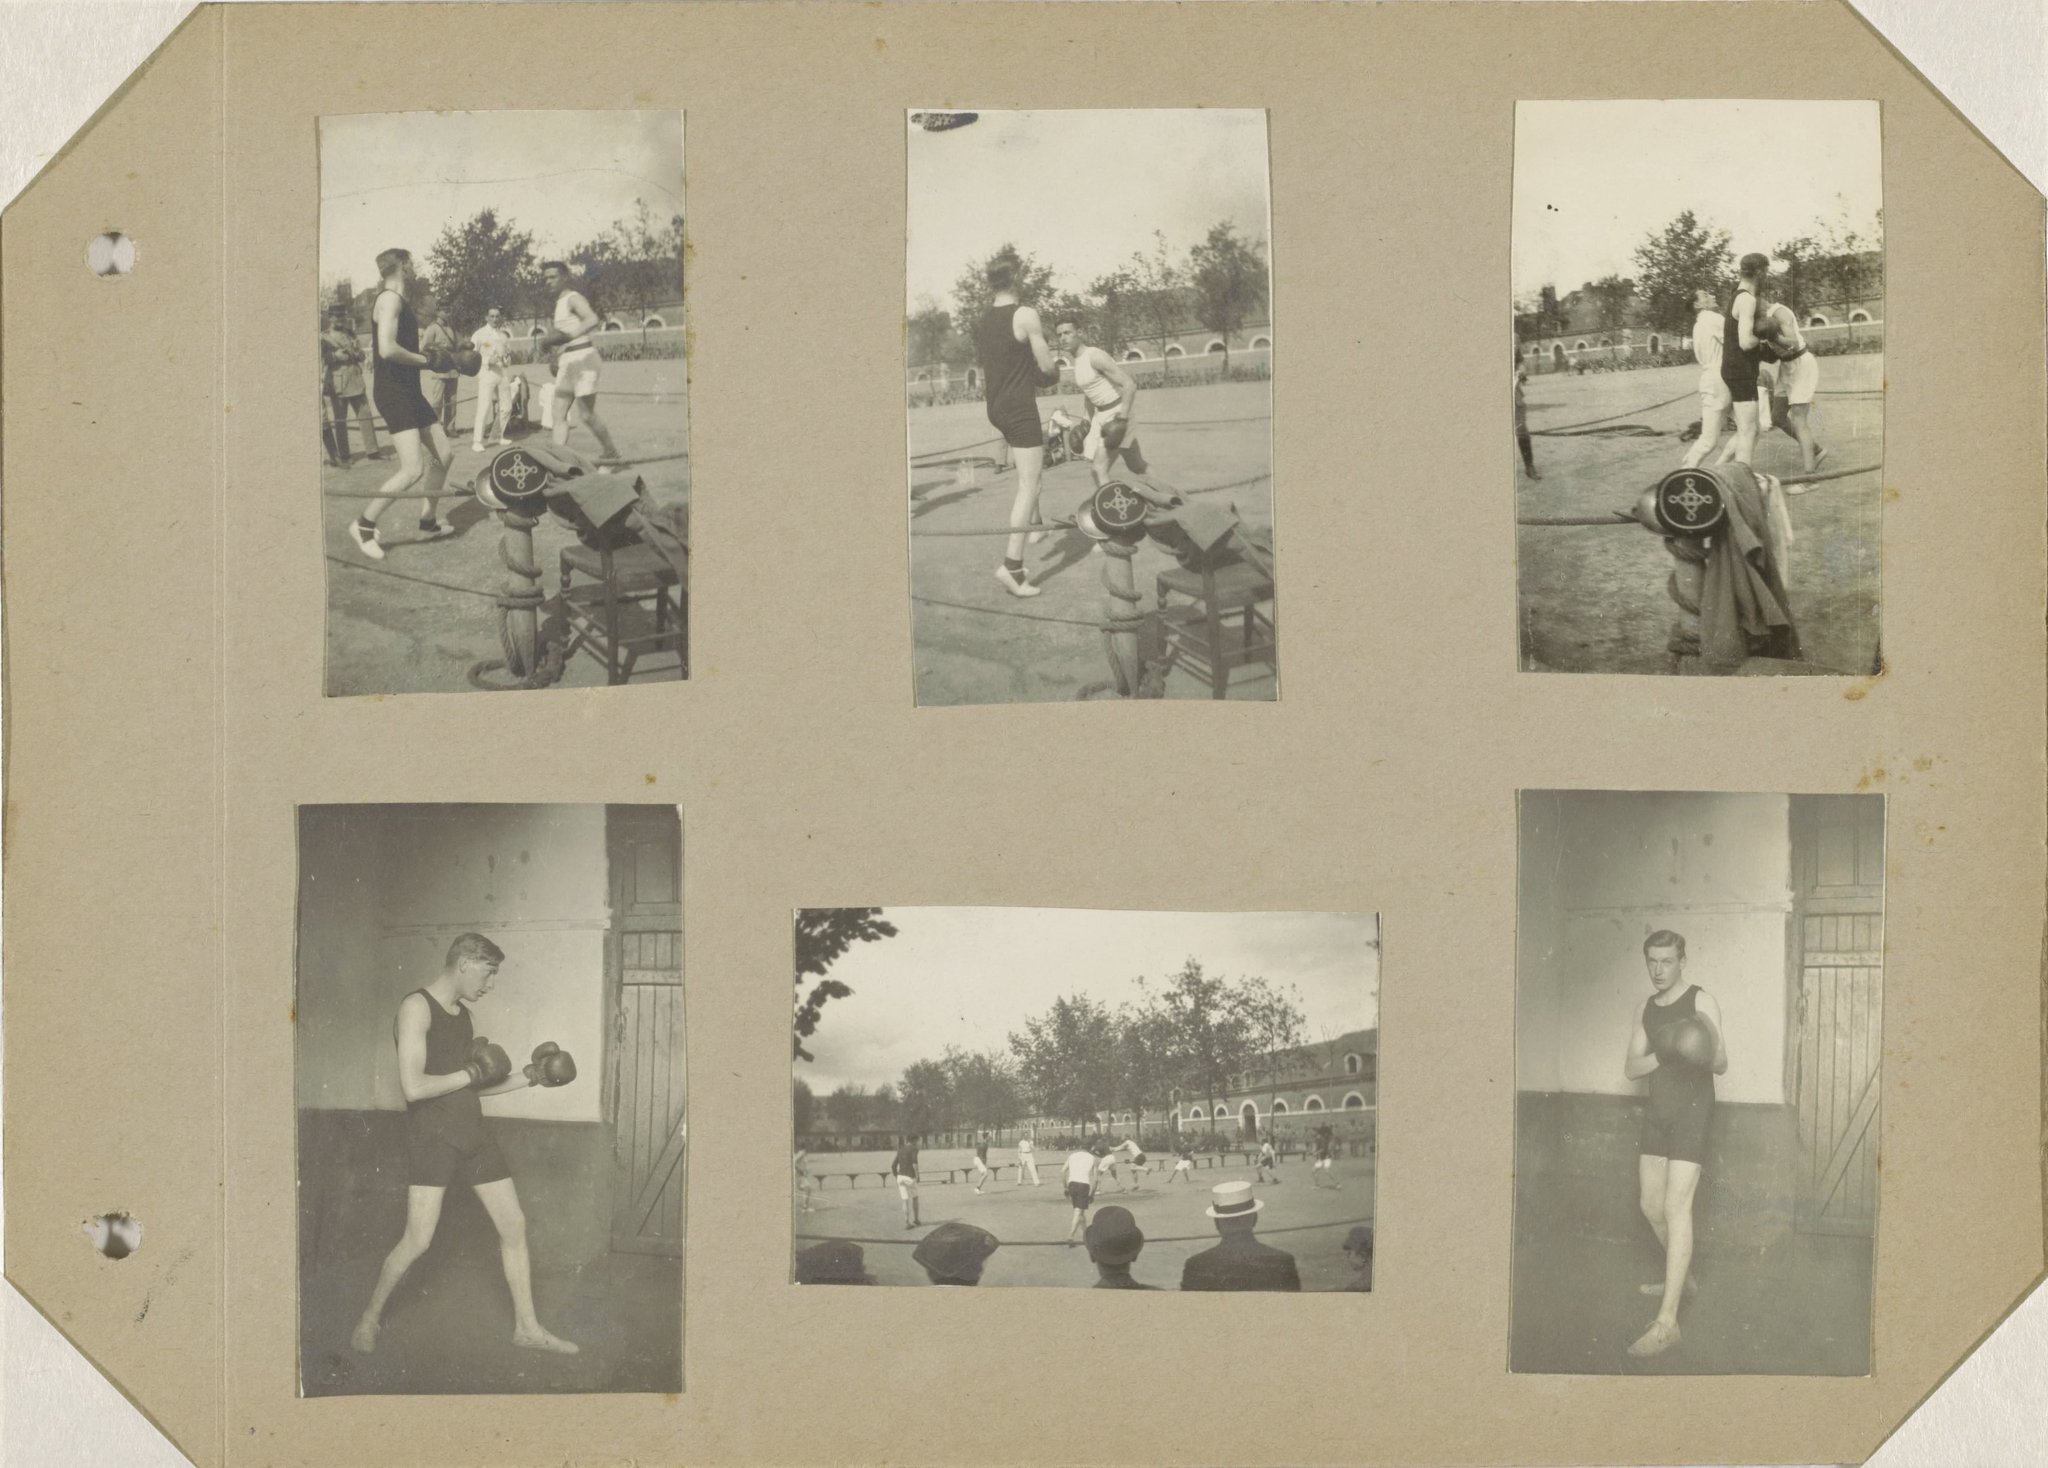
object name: photograph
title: Albumblad met zes foto's van een bokser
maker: Anonymous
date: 1920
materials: paper, photographic support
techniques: gelatin silver print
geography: netherlands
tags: boxing (sport)